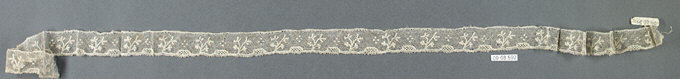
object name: piece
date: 1801-1900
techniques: lace